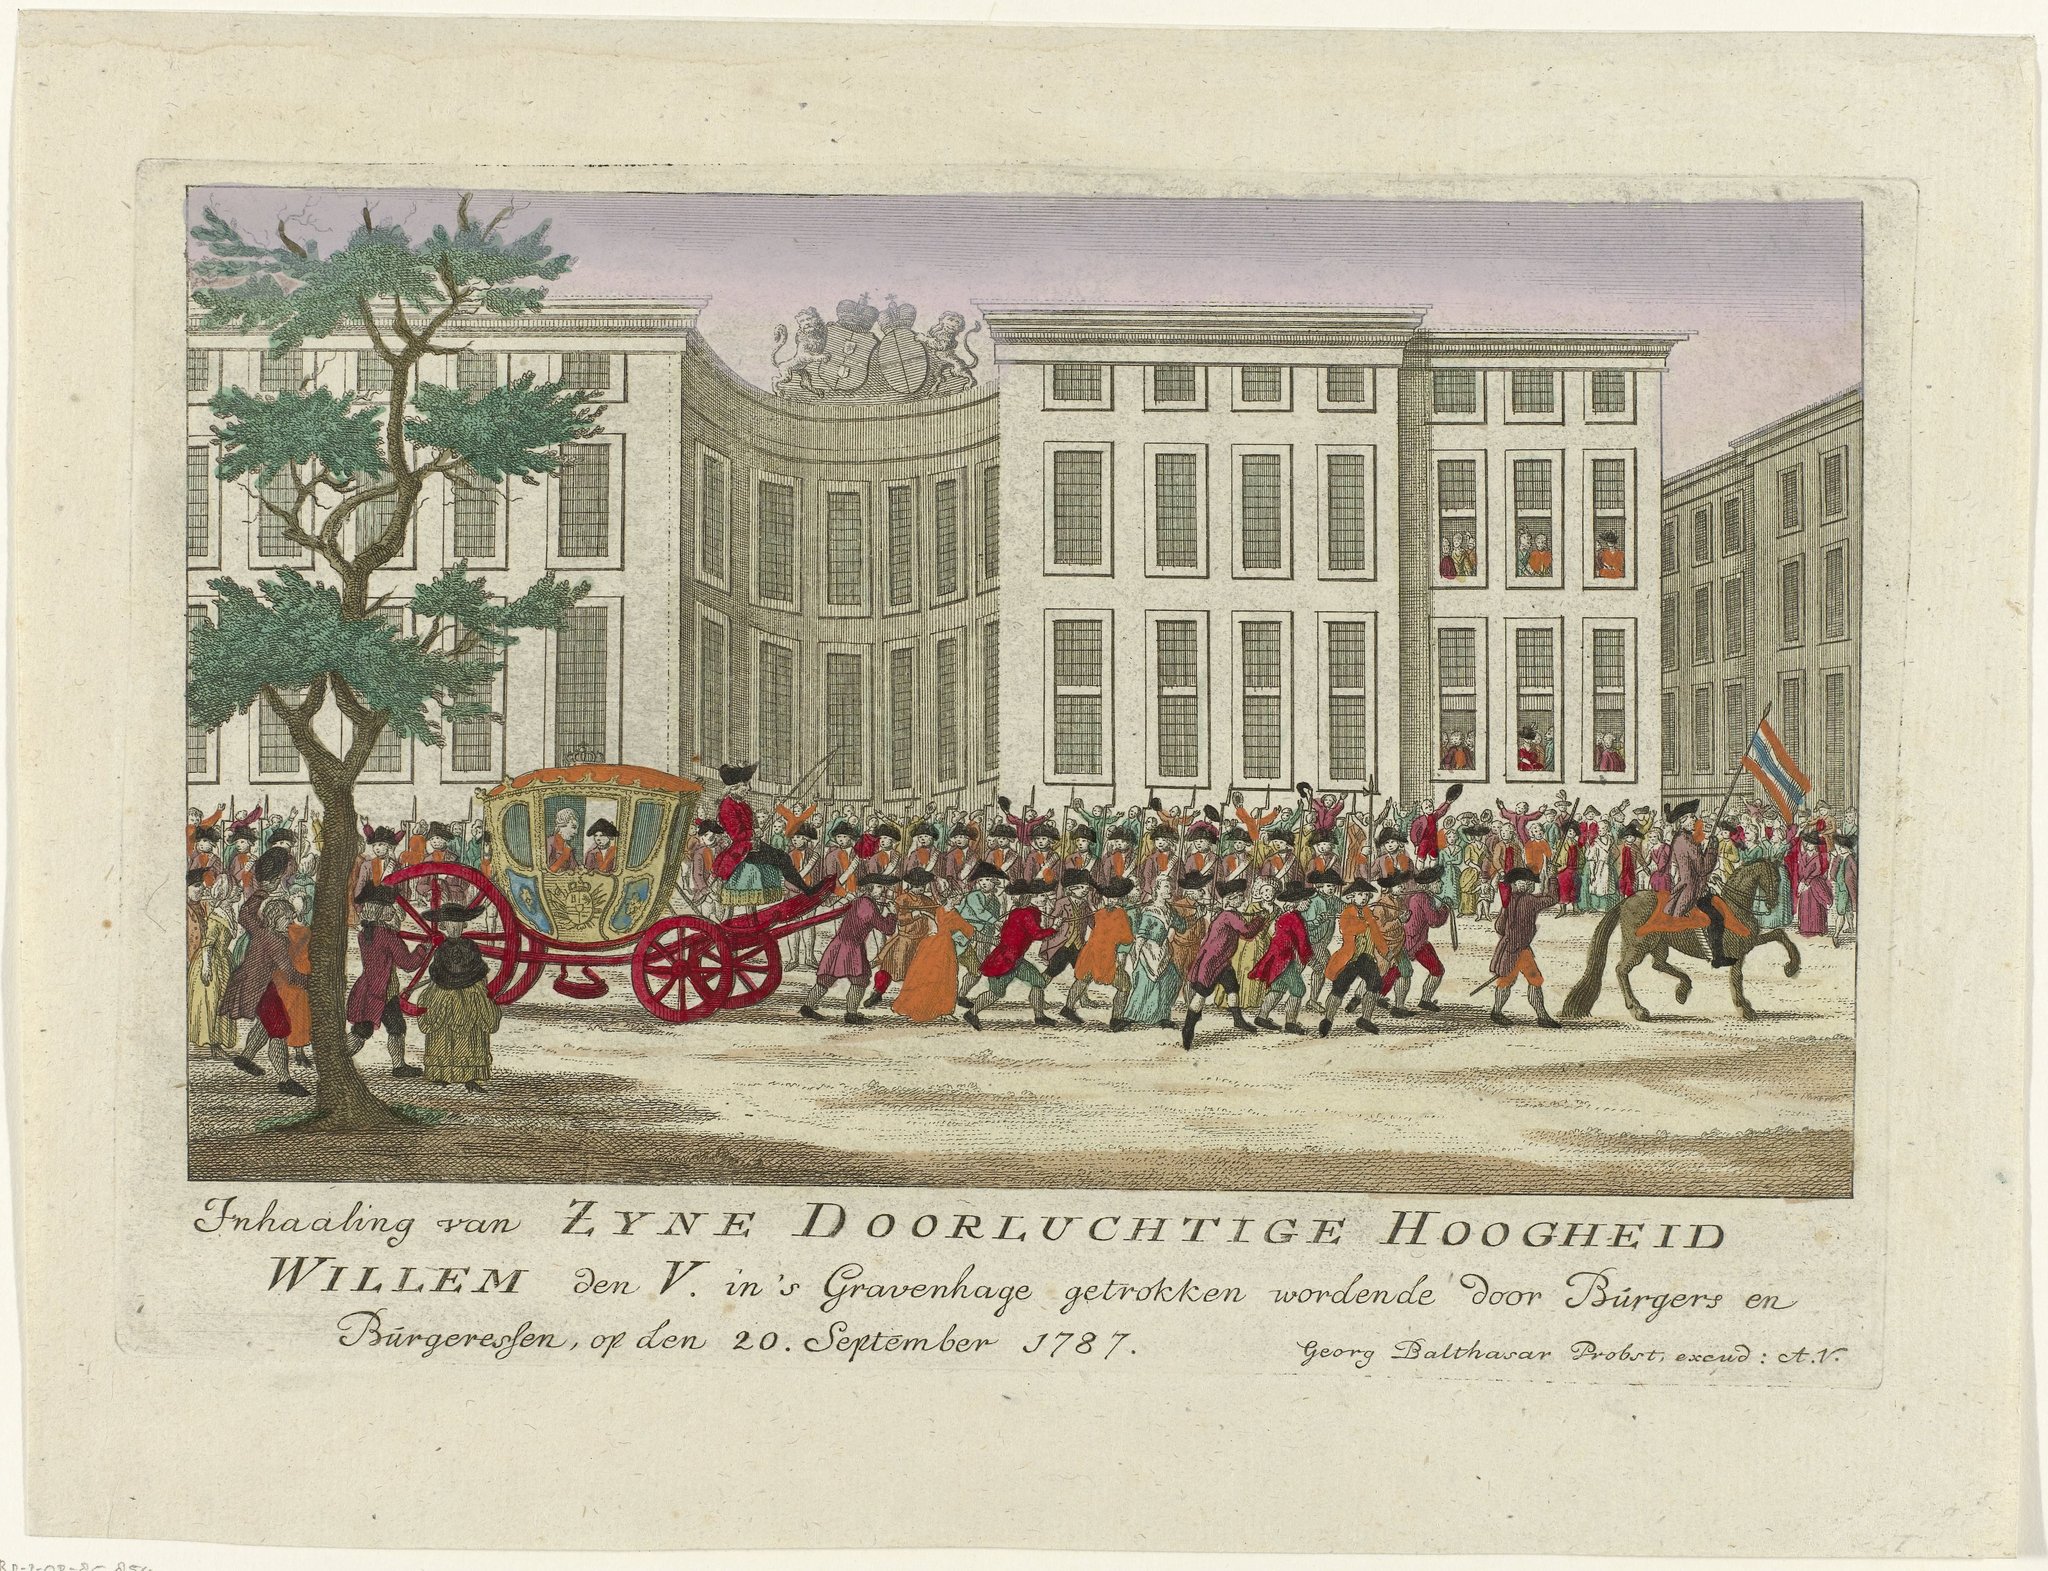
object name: print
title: Inhaaling van Zyne Doorluchtige Hoogheid Willem den V. in 's Gravenhage getrokken wordende door Burgers en Burgeressen, op den 20. September 1787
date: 1787-1790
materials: paper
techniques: etching, hand coloring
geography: augsburg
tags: william v (prince of orange), public festivities at other royal events, not meant or mentioned above, human being(s) drawing or pushing a vehicle not usually propelled by manpower, the hague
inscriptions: collector's mark: Lugt 2228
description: Inhaling van de prins van Oranje door de burgerij te Den Haag, 20 september 1787. De open koets met stadhouder Willem V wordt door mannen en vrouwen over de weg langs het Paleis van Nassau-Weilburg getrokken.